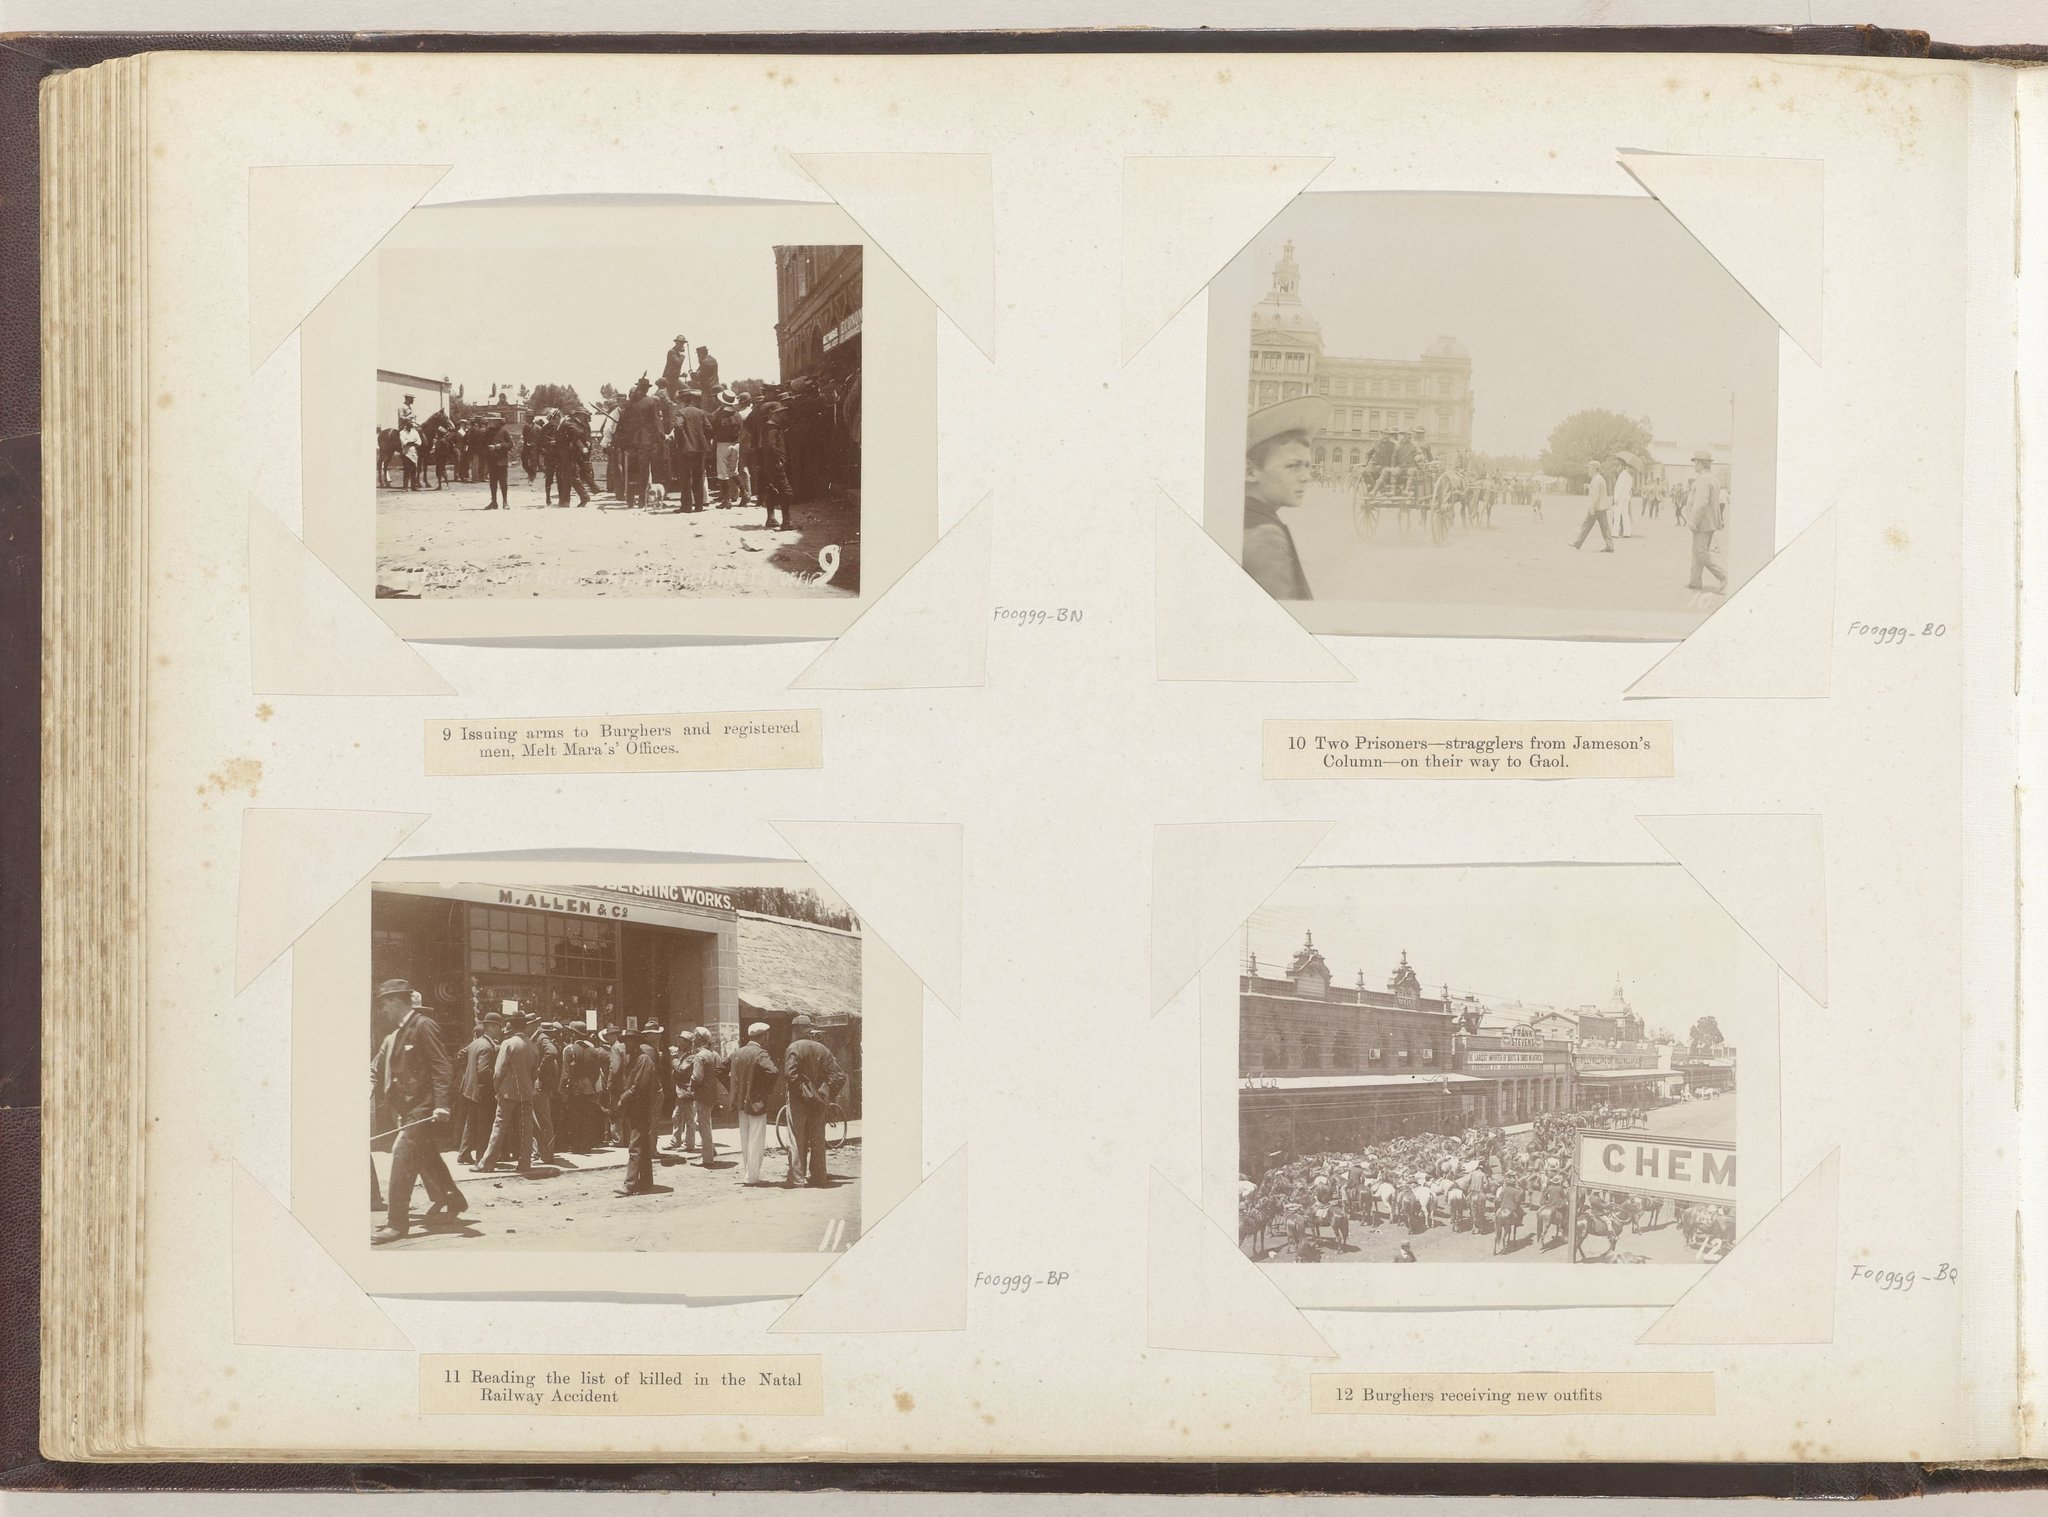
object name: photograph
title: Uitgifte van wapens in Zuid-Afrika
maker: Anonymous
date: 1896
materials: paper, photographic support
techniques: gelatin silver print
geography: south africa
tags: street (+ city(-scape) with figures, staffage)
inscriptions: inscription: ‘Giving out rifles at [...] Office 9’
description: Onderdeel van Album met 191 foto's van een reis naar en door Zuid-Afrika.